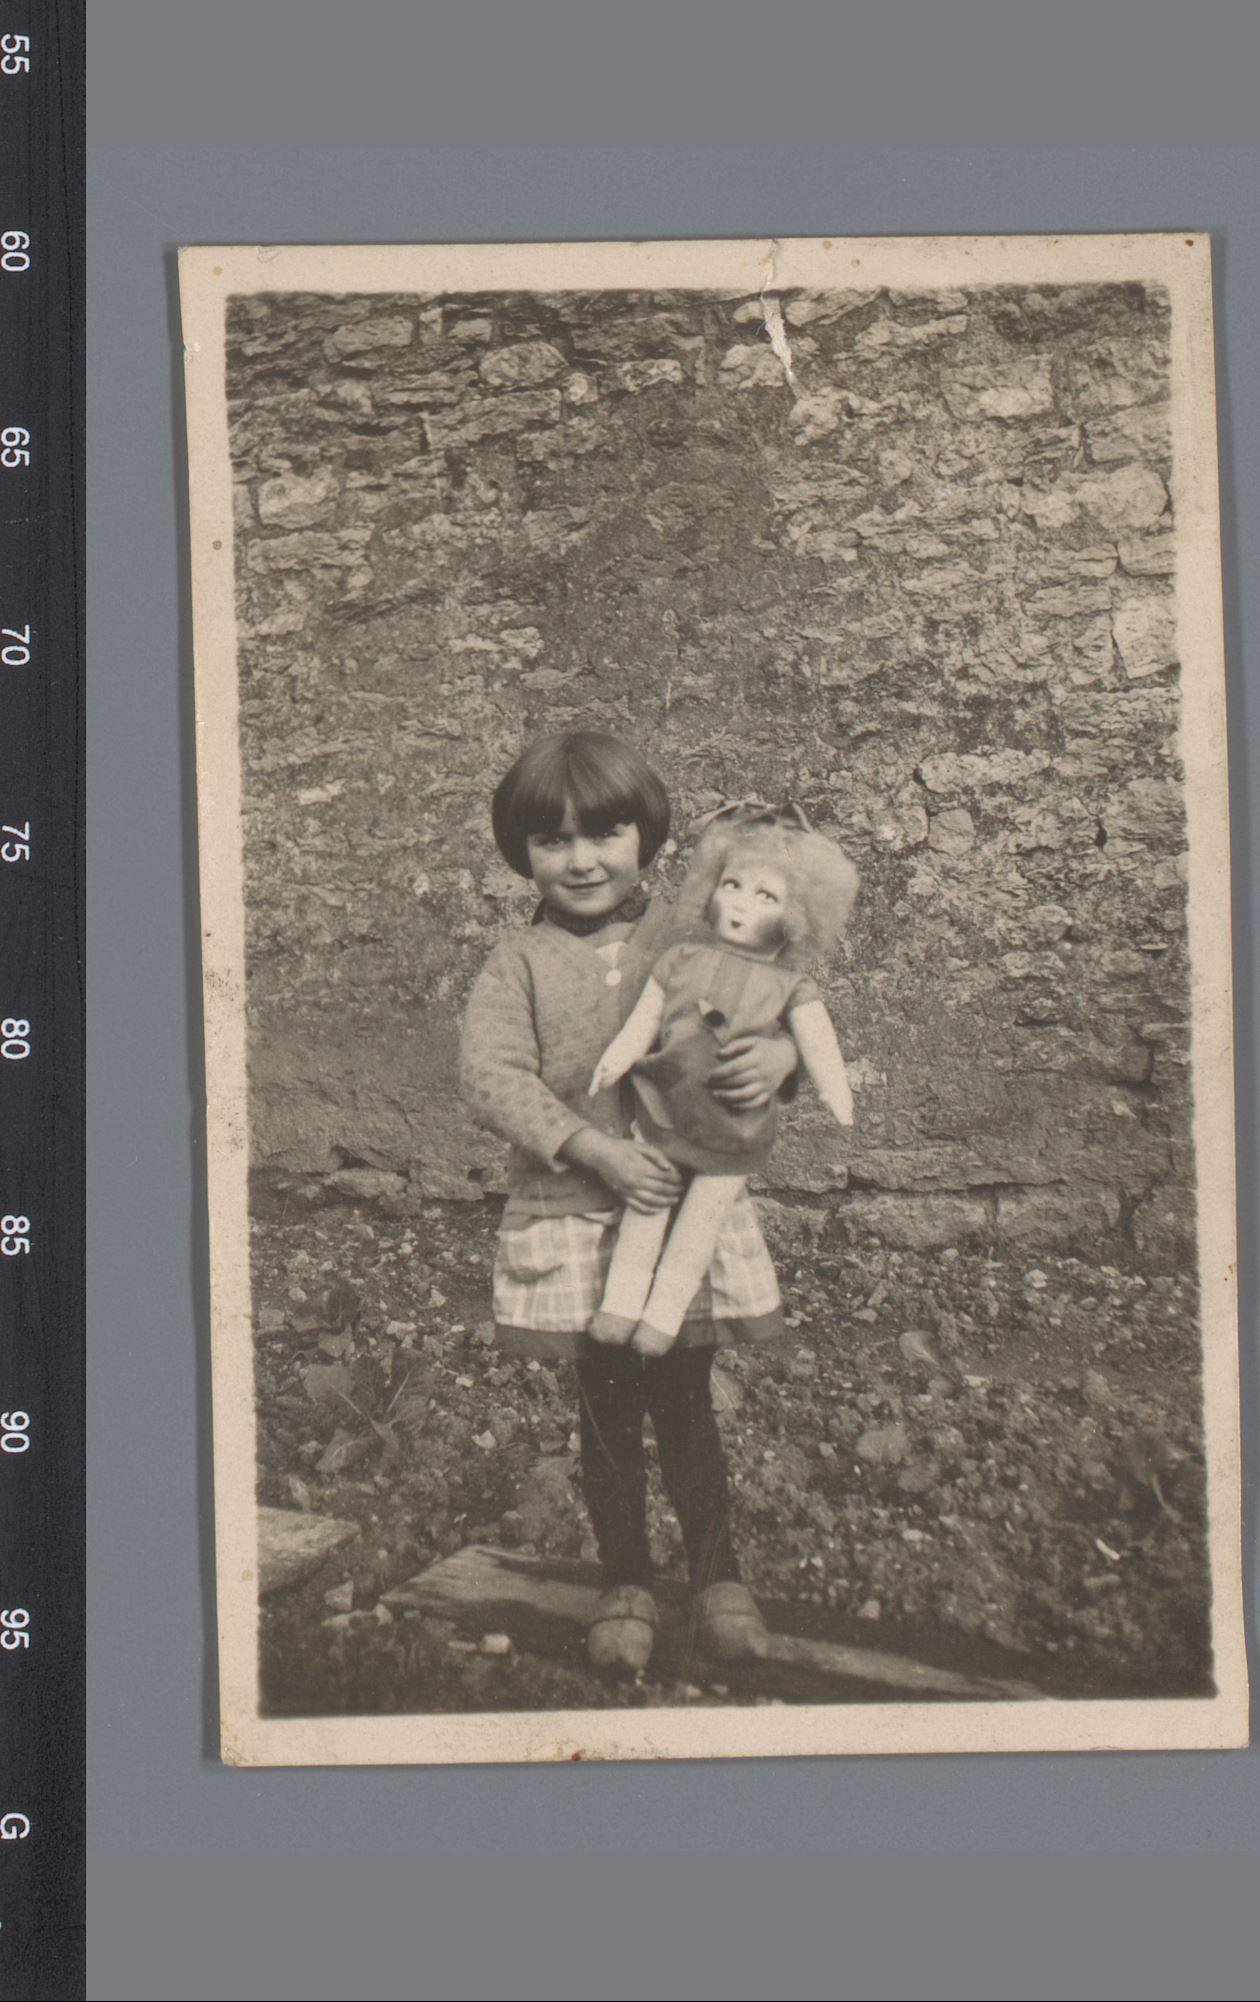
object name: photograph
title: Portret van een onbekend meisje met een pop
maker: Anonymous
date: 1920-1930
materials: paper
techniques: gelatin silver print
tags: girl (child between toddler and youth), anonymous historical person portrayed, (playing with) dolls